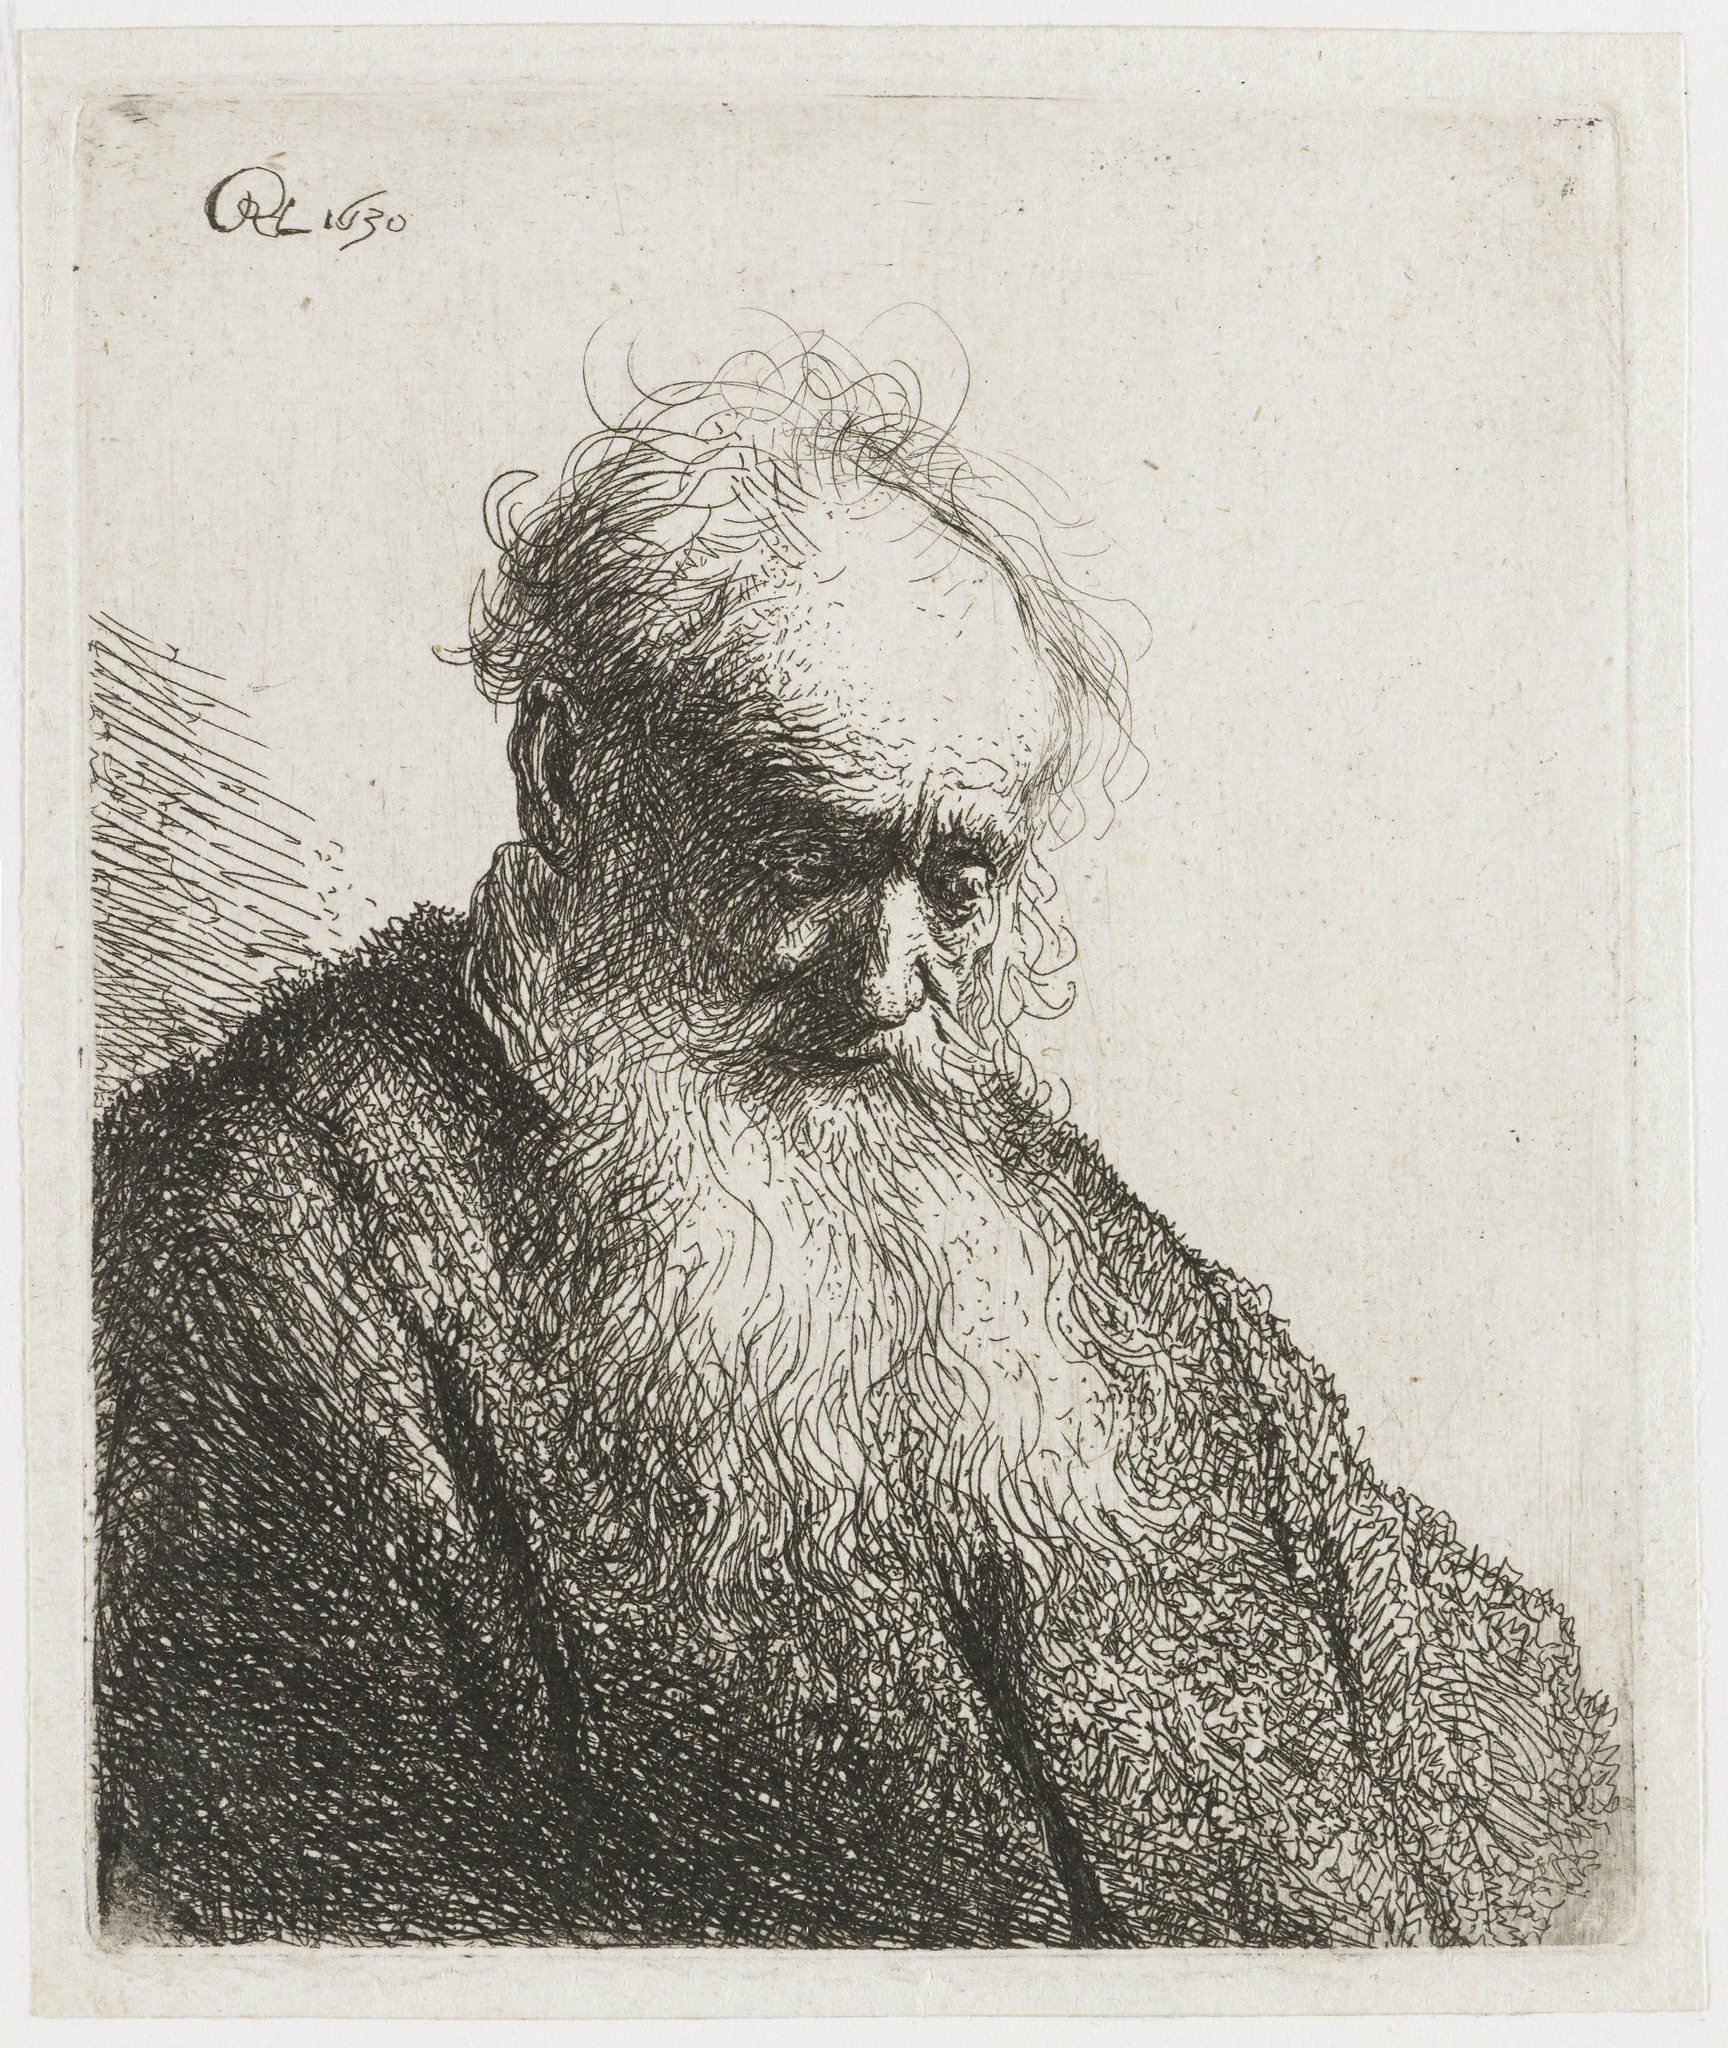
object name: print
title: Old man with a flowing beard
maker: rembrandt van rijn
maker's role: draughtsman, painter, print maker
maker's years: 1606-1669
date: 1630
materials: paper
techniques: etching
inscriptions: collector's mark: Lugt 240, monogram and date: ‘RHL 1630’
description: In these prints, Rembrandt studies the characteristics of age, always portraying the same full-bearded man. While slight differences can certainly be discerned, Rembrandt’s penchant for depicting his models while they look down, their heads slightly bent, is striking. This pose lends the studies a melancholy air.